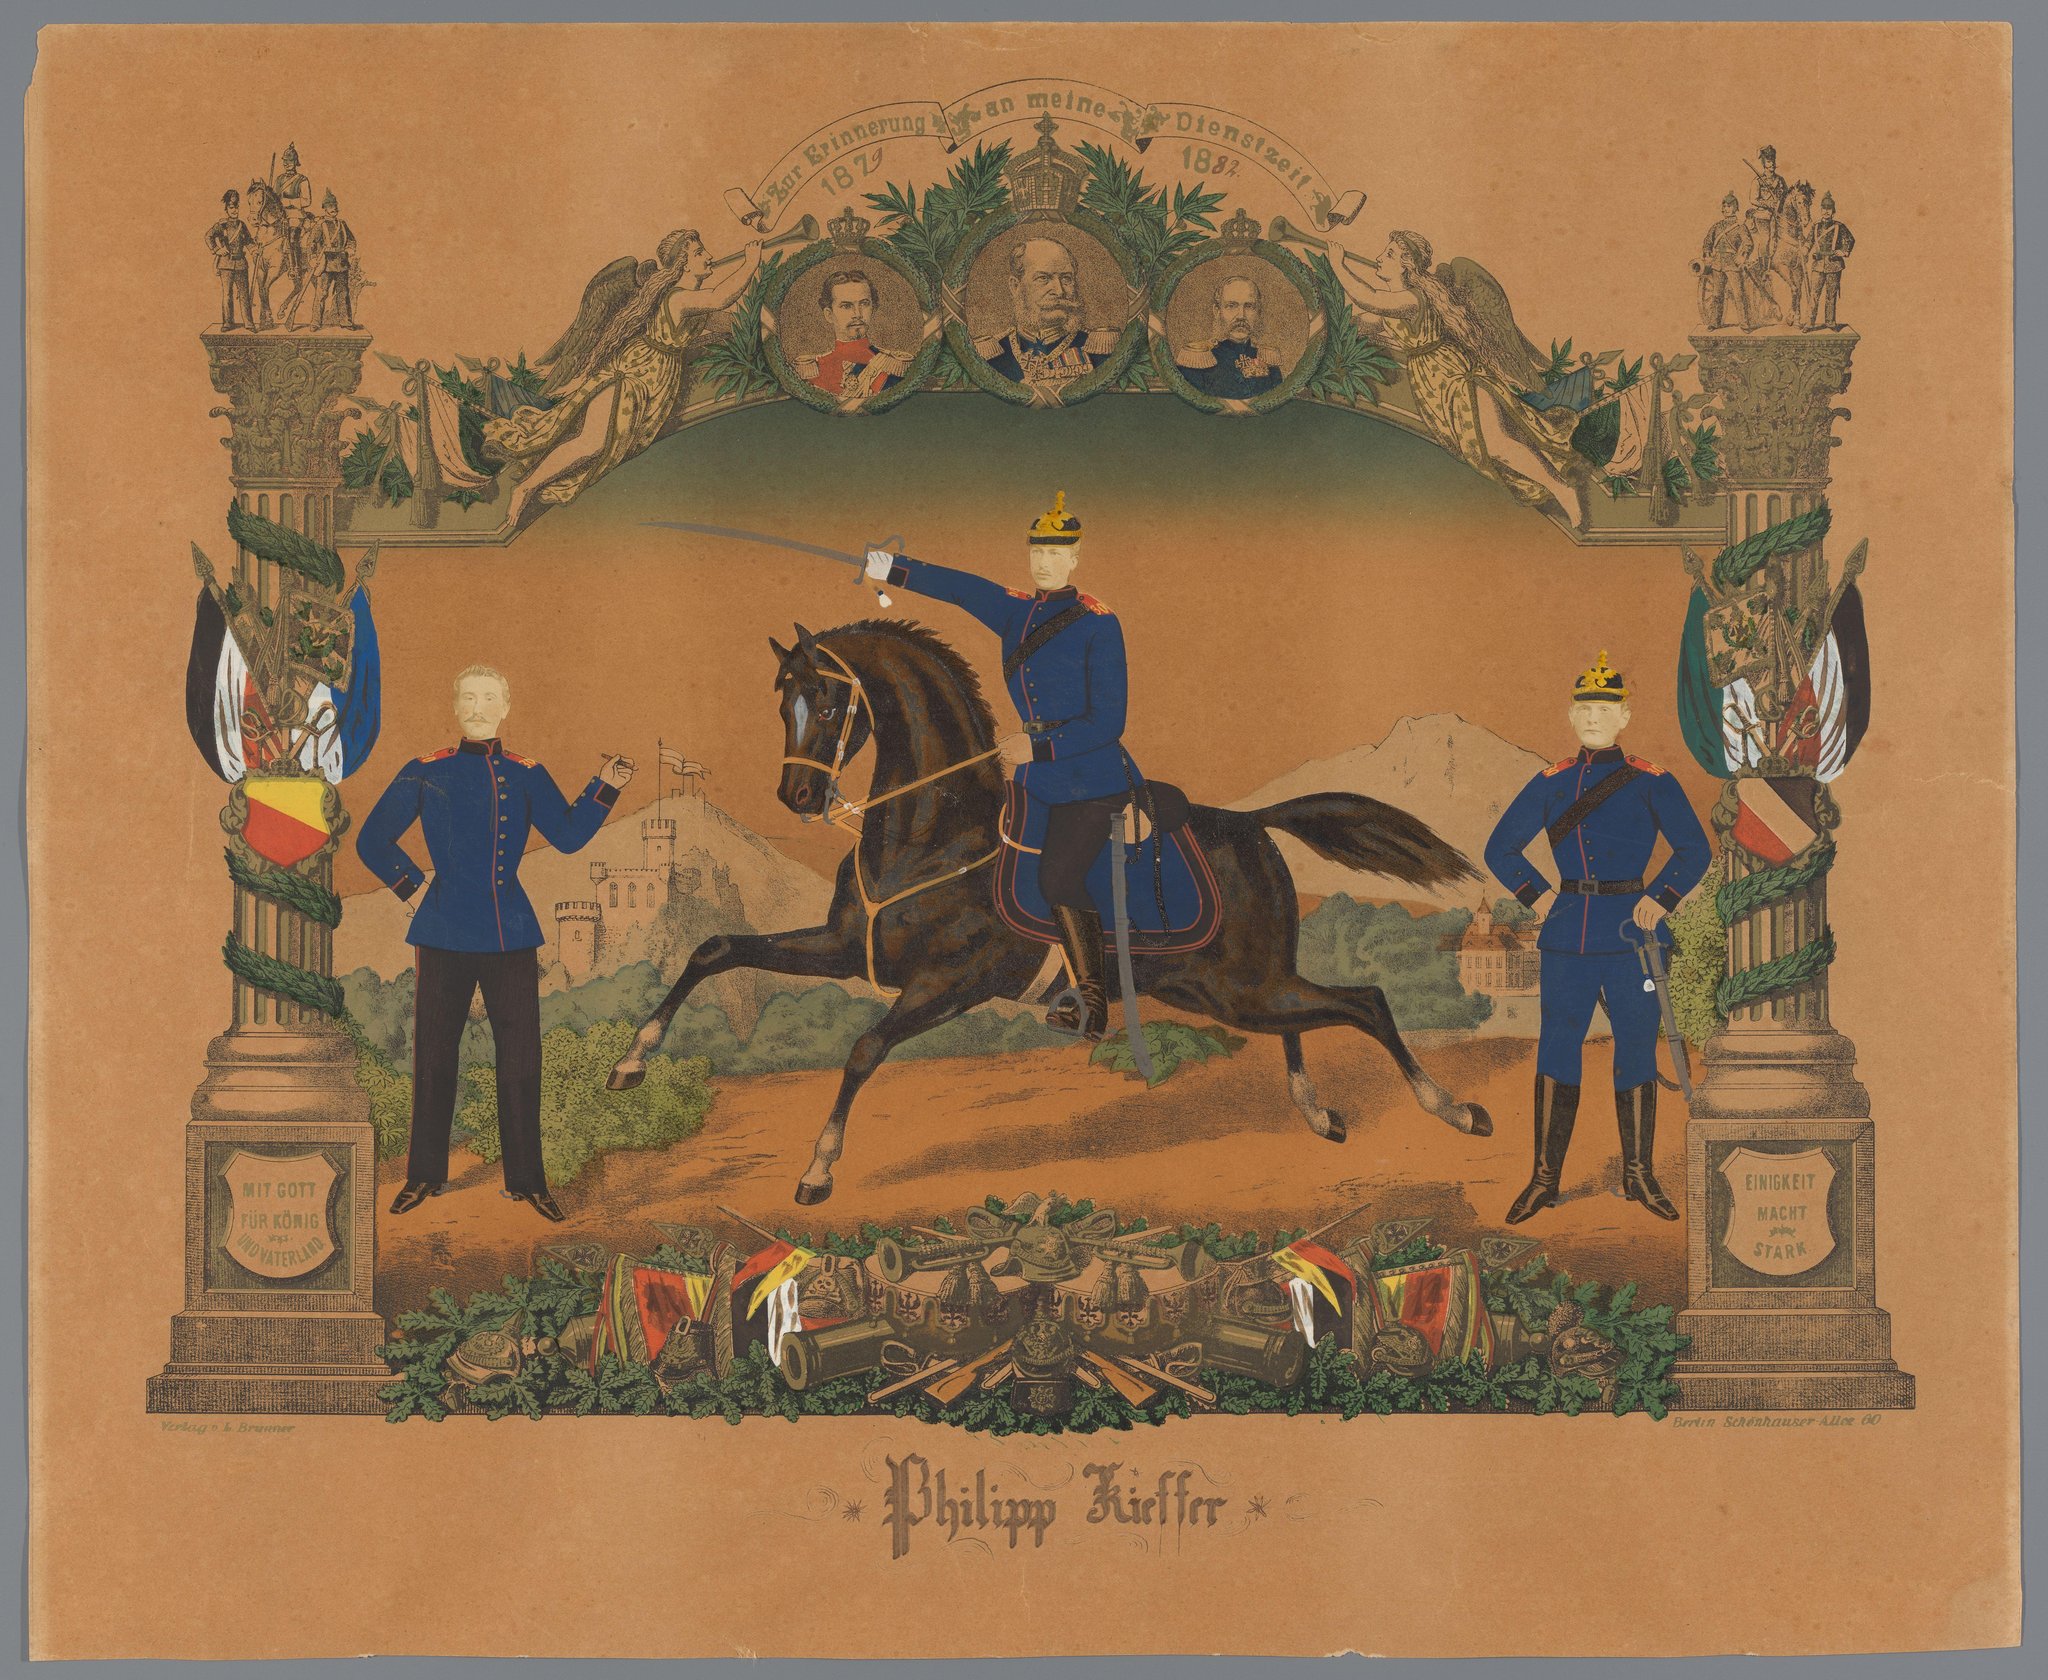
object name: photograph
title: Portret van een Duitse militair (cavalerist) te paard, Philipp Kieffer, 1882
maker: l. brenner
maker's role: publisher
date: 1882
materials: paint, paper, photographic support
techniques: albumen print, lithograph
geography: berlin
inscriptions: inscription: ‘Kiefer Schmidt’, inscription: ‘[onleesbaar]’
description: Tableau van gemonteerde foto's ('Zur Erinnerung an meine Dienstzeit') van Philipp Kieffer. Middenboven portretten van keizer Wilhelm I, keizer Franz Joseph I (?) en.